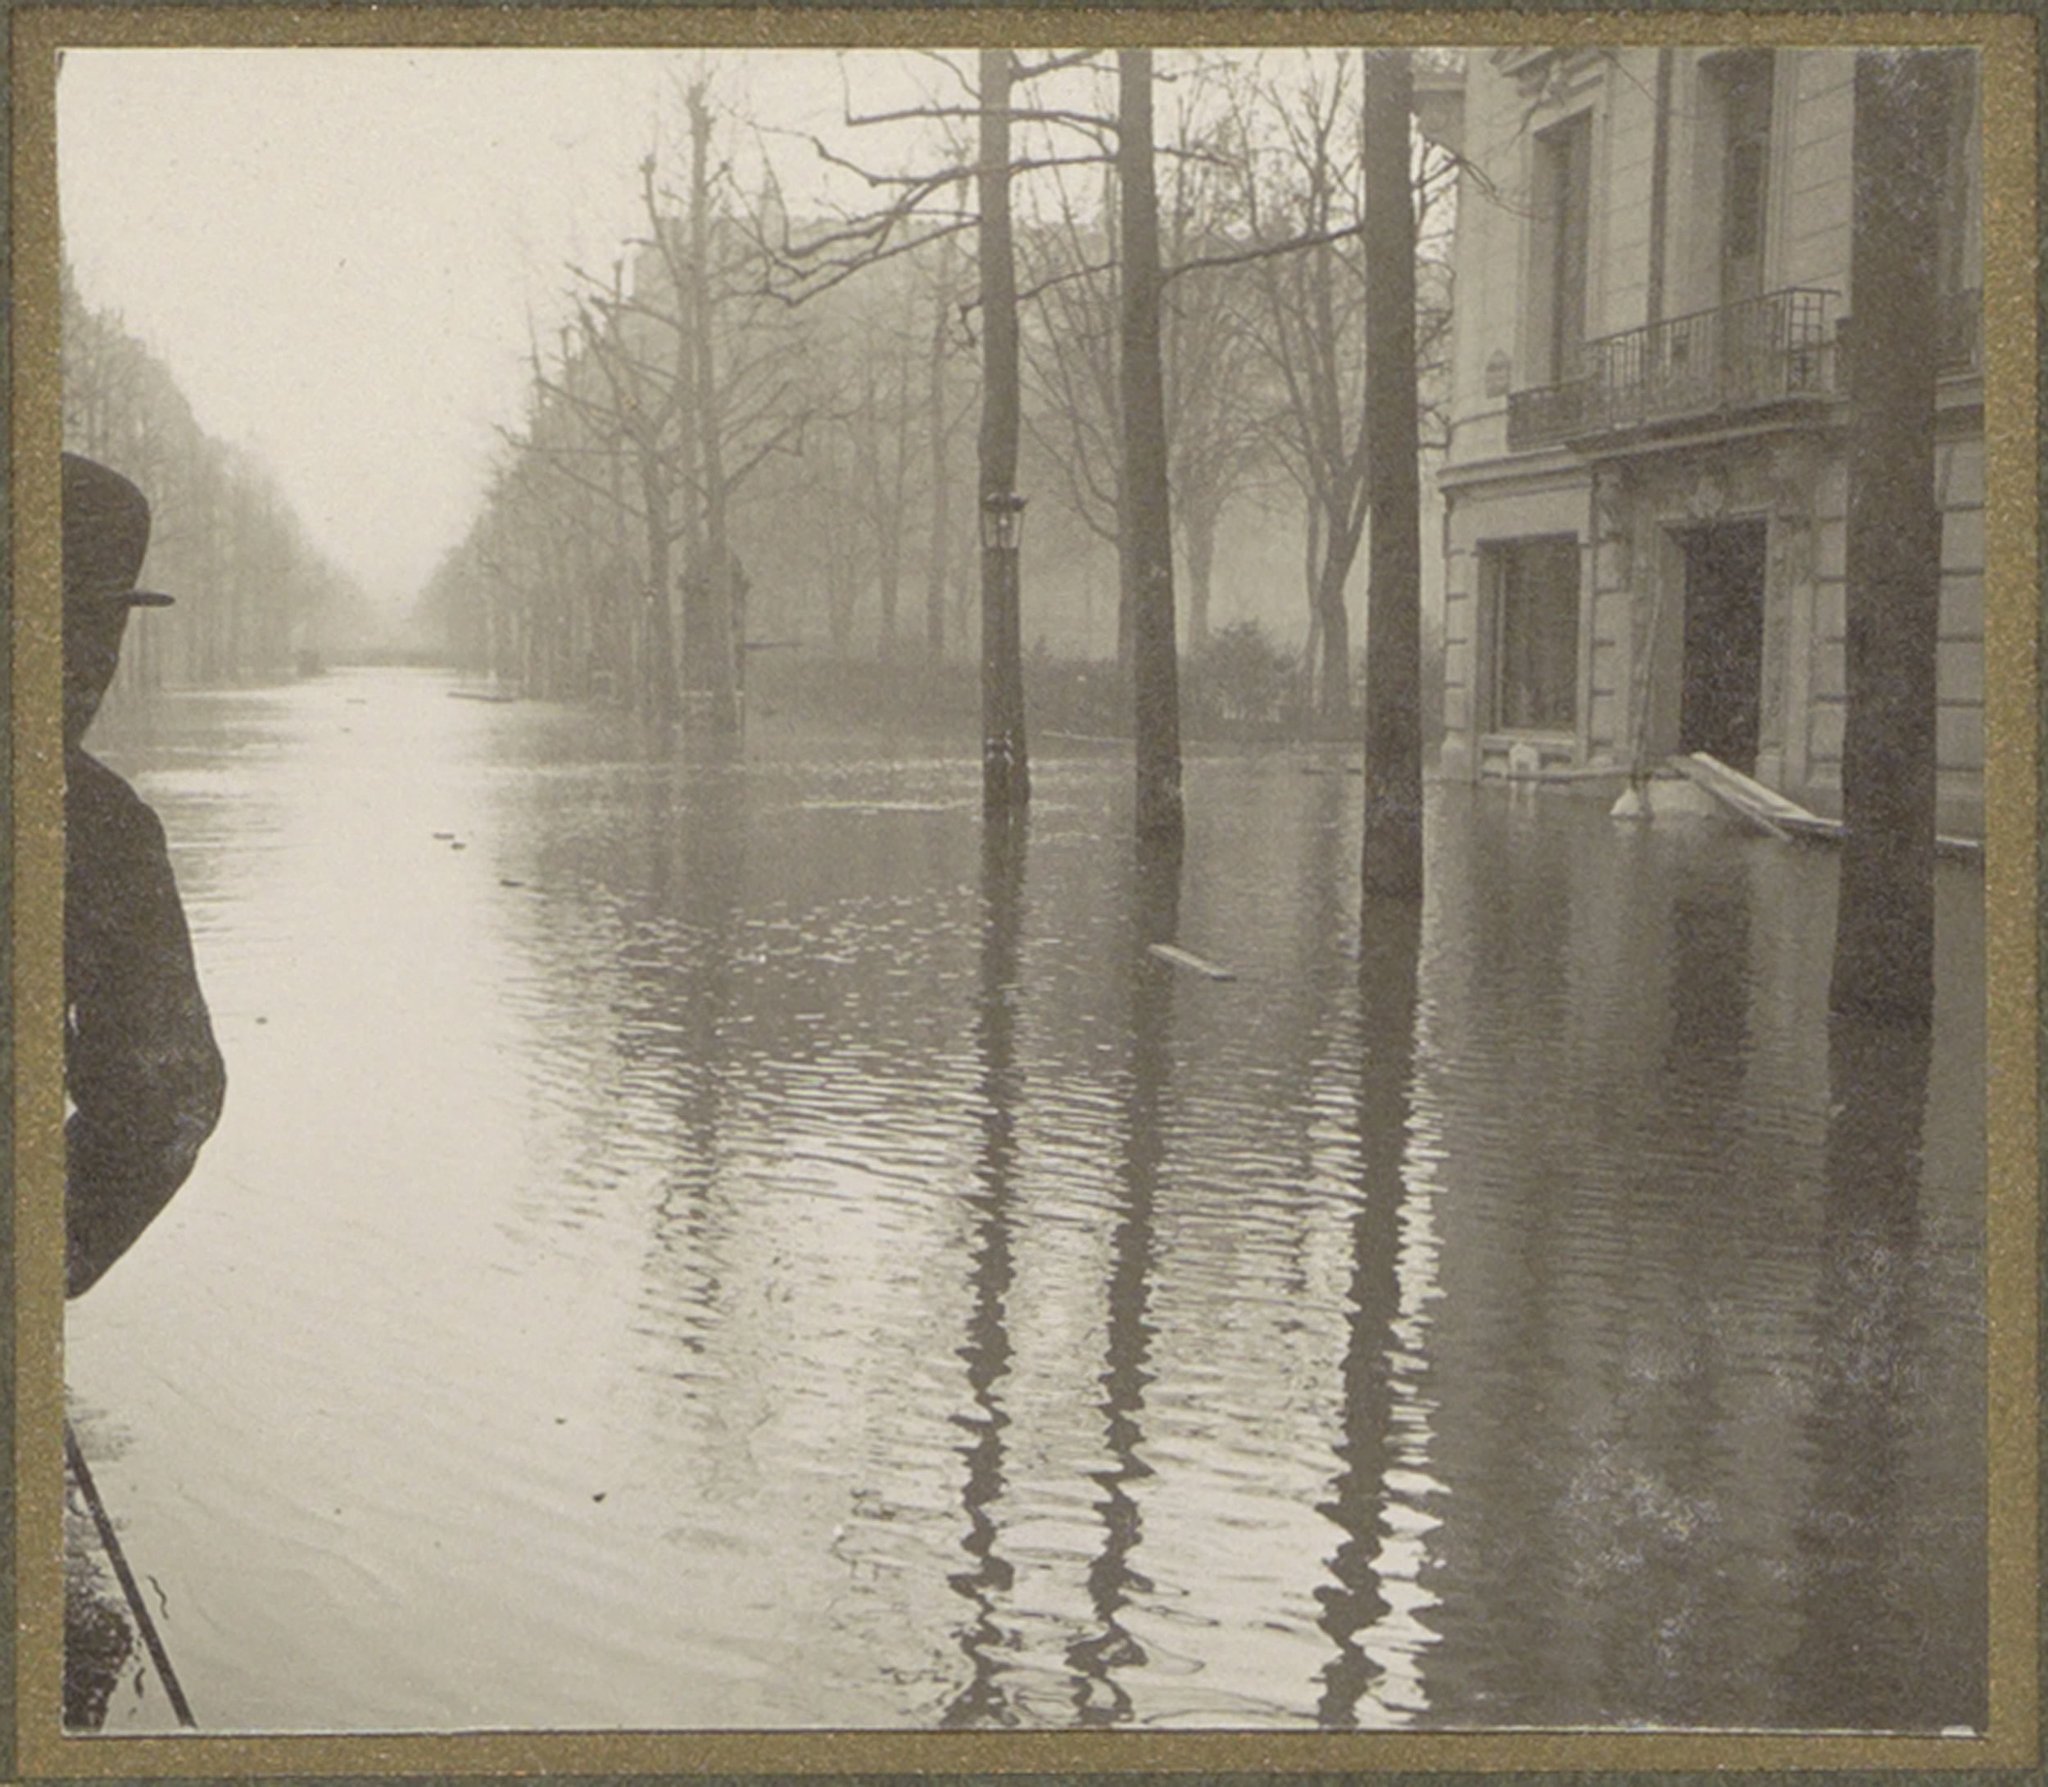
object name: photograph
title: Ondergelopen straat met bomen, gezien vanuit een bootje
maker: g. dangereux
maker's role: fotograaf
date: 1901-1910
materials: photographic support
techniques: matte daylight collodion silver print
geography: paris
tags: rescue work during a flood (+ landscape with figures, staffage), paris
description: Onderdeel van fotoalbum overstroming Parijs en voorsteden 1910.